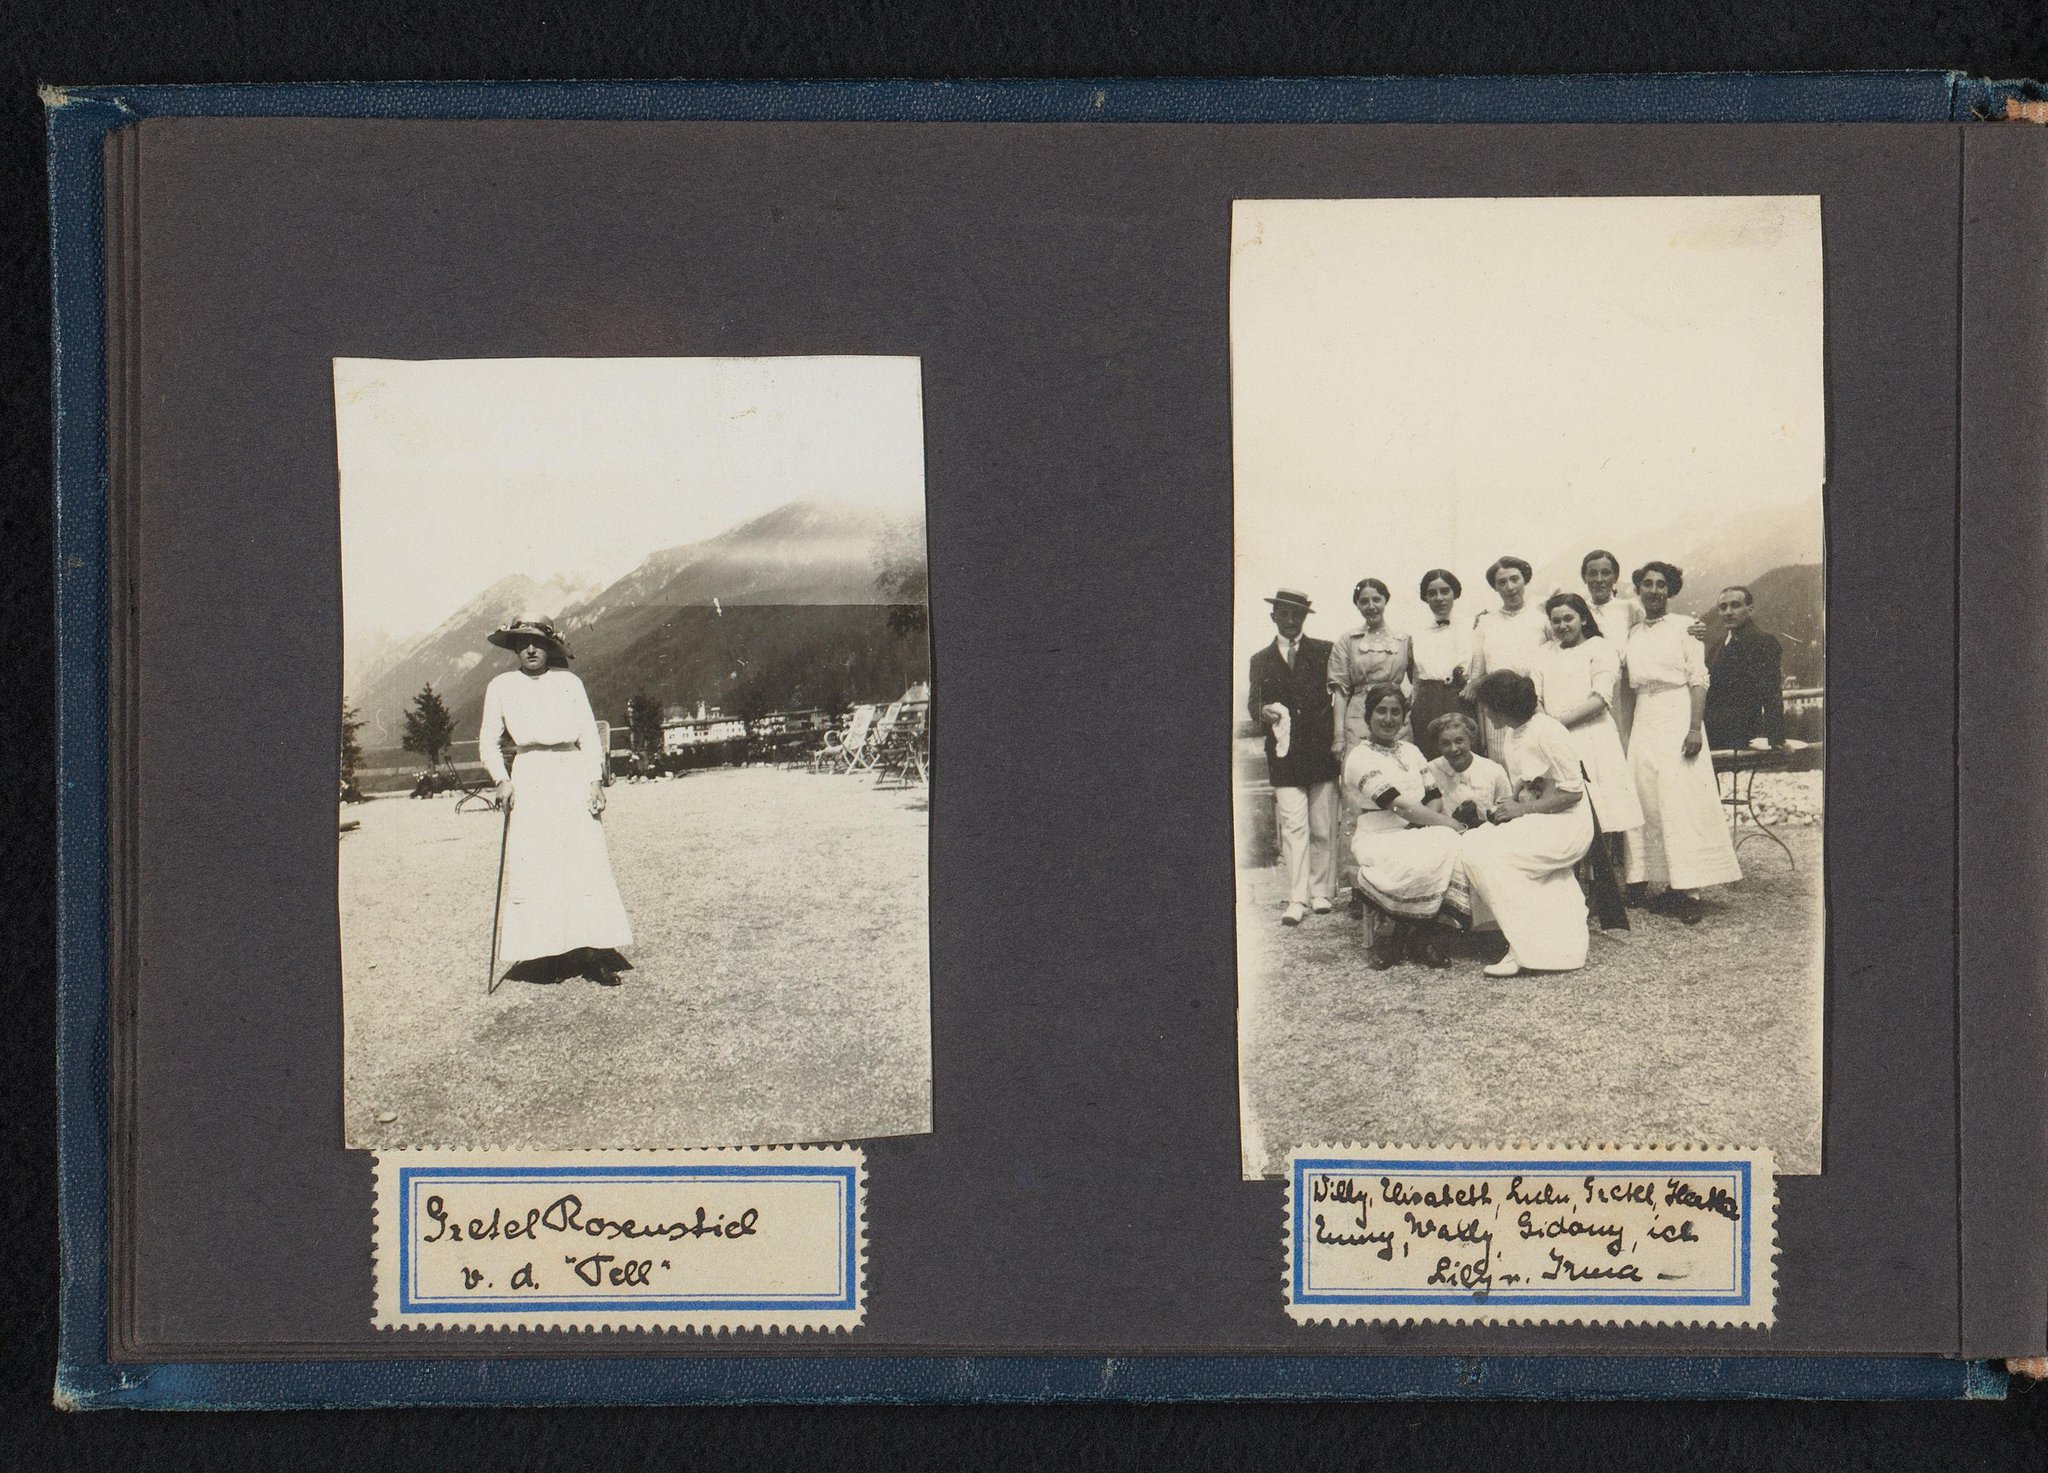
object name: album leaf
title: Portret en groepsportret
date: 1913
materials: paper, photographic support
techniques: gelatin silver print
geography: switzerland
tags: else wachenheimer-moos, willy moos, historical persons - bb - woman, historical persons, anonymous historical persons portrayed in a group, in a group-portrait, switzerland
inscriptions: inscription: ‘Gretel Rosenstiel v.d. "Tell"/ Willy, Elisabeth, Lulu, Gretel, Heike, Emmy, Wally, Sidony, ich, Lily u. Irma.’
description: Albumblad met twee foto's met een portret en een groepsportret met Else en Willy, in Zwitserland. Onderdeel van het fotoalbum van Else Wachenheimer-Moos en haar broers Arthur en Willy Moos en anderen in de periode 1913-1918.